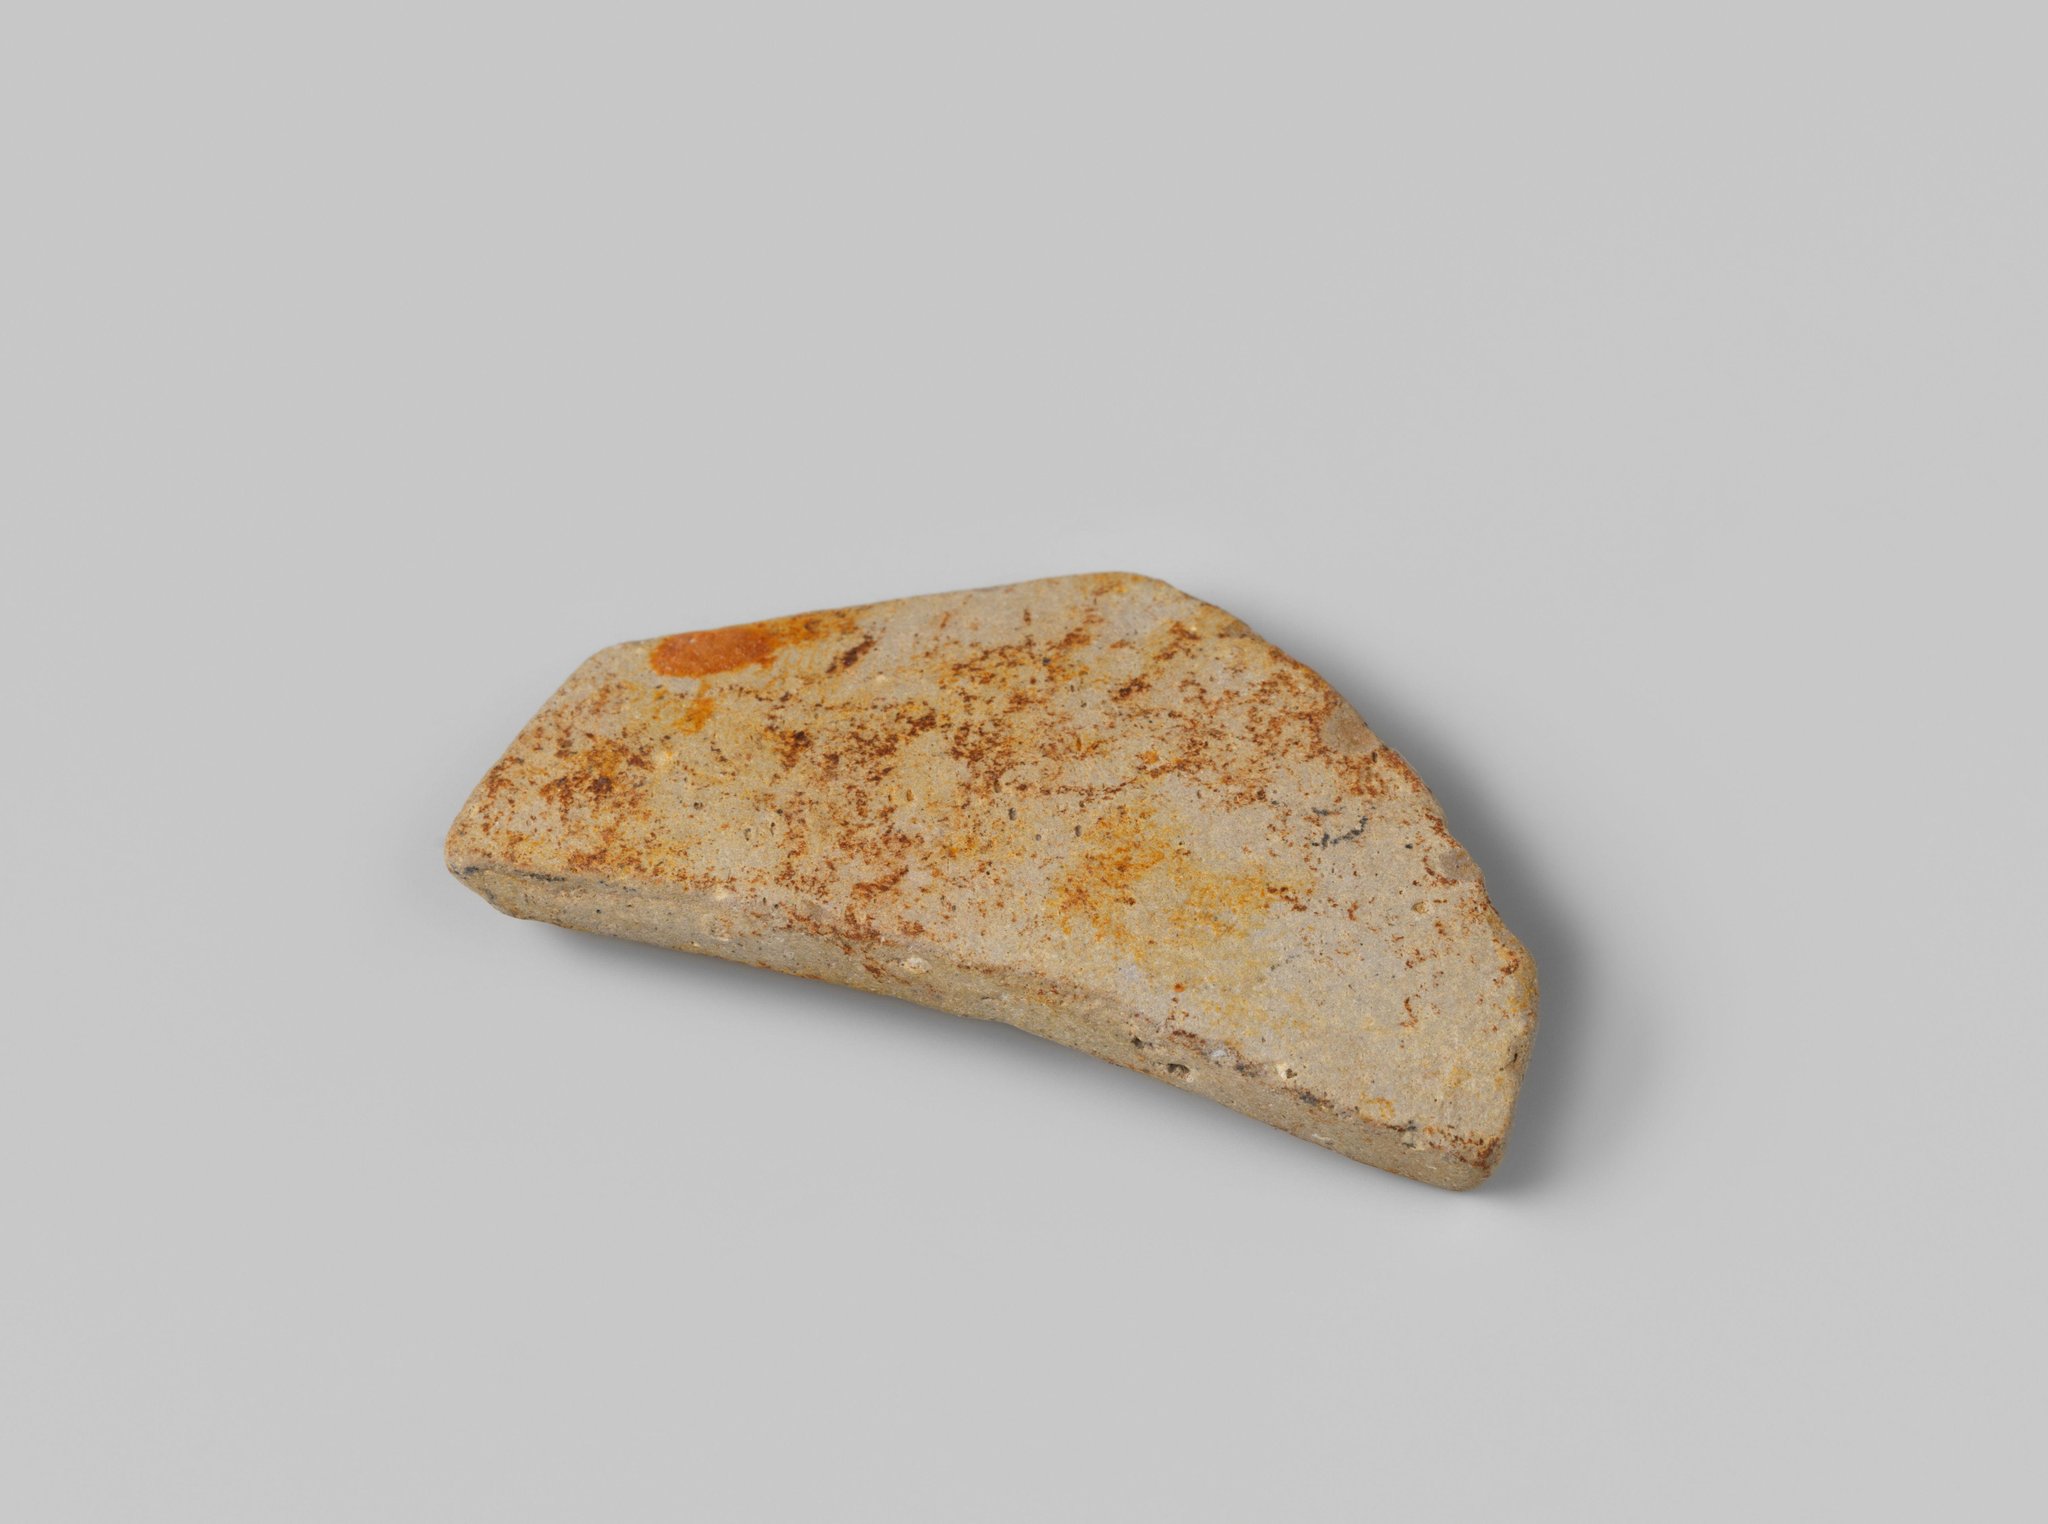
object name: sherd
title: Scherf van een kan uit het wrak van de Oostindiëvaarder Hollandia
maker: Anonymous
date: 1700-1743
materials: stoneware